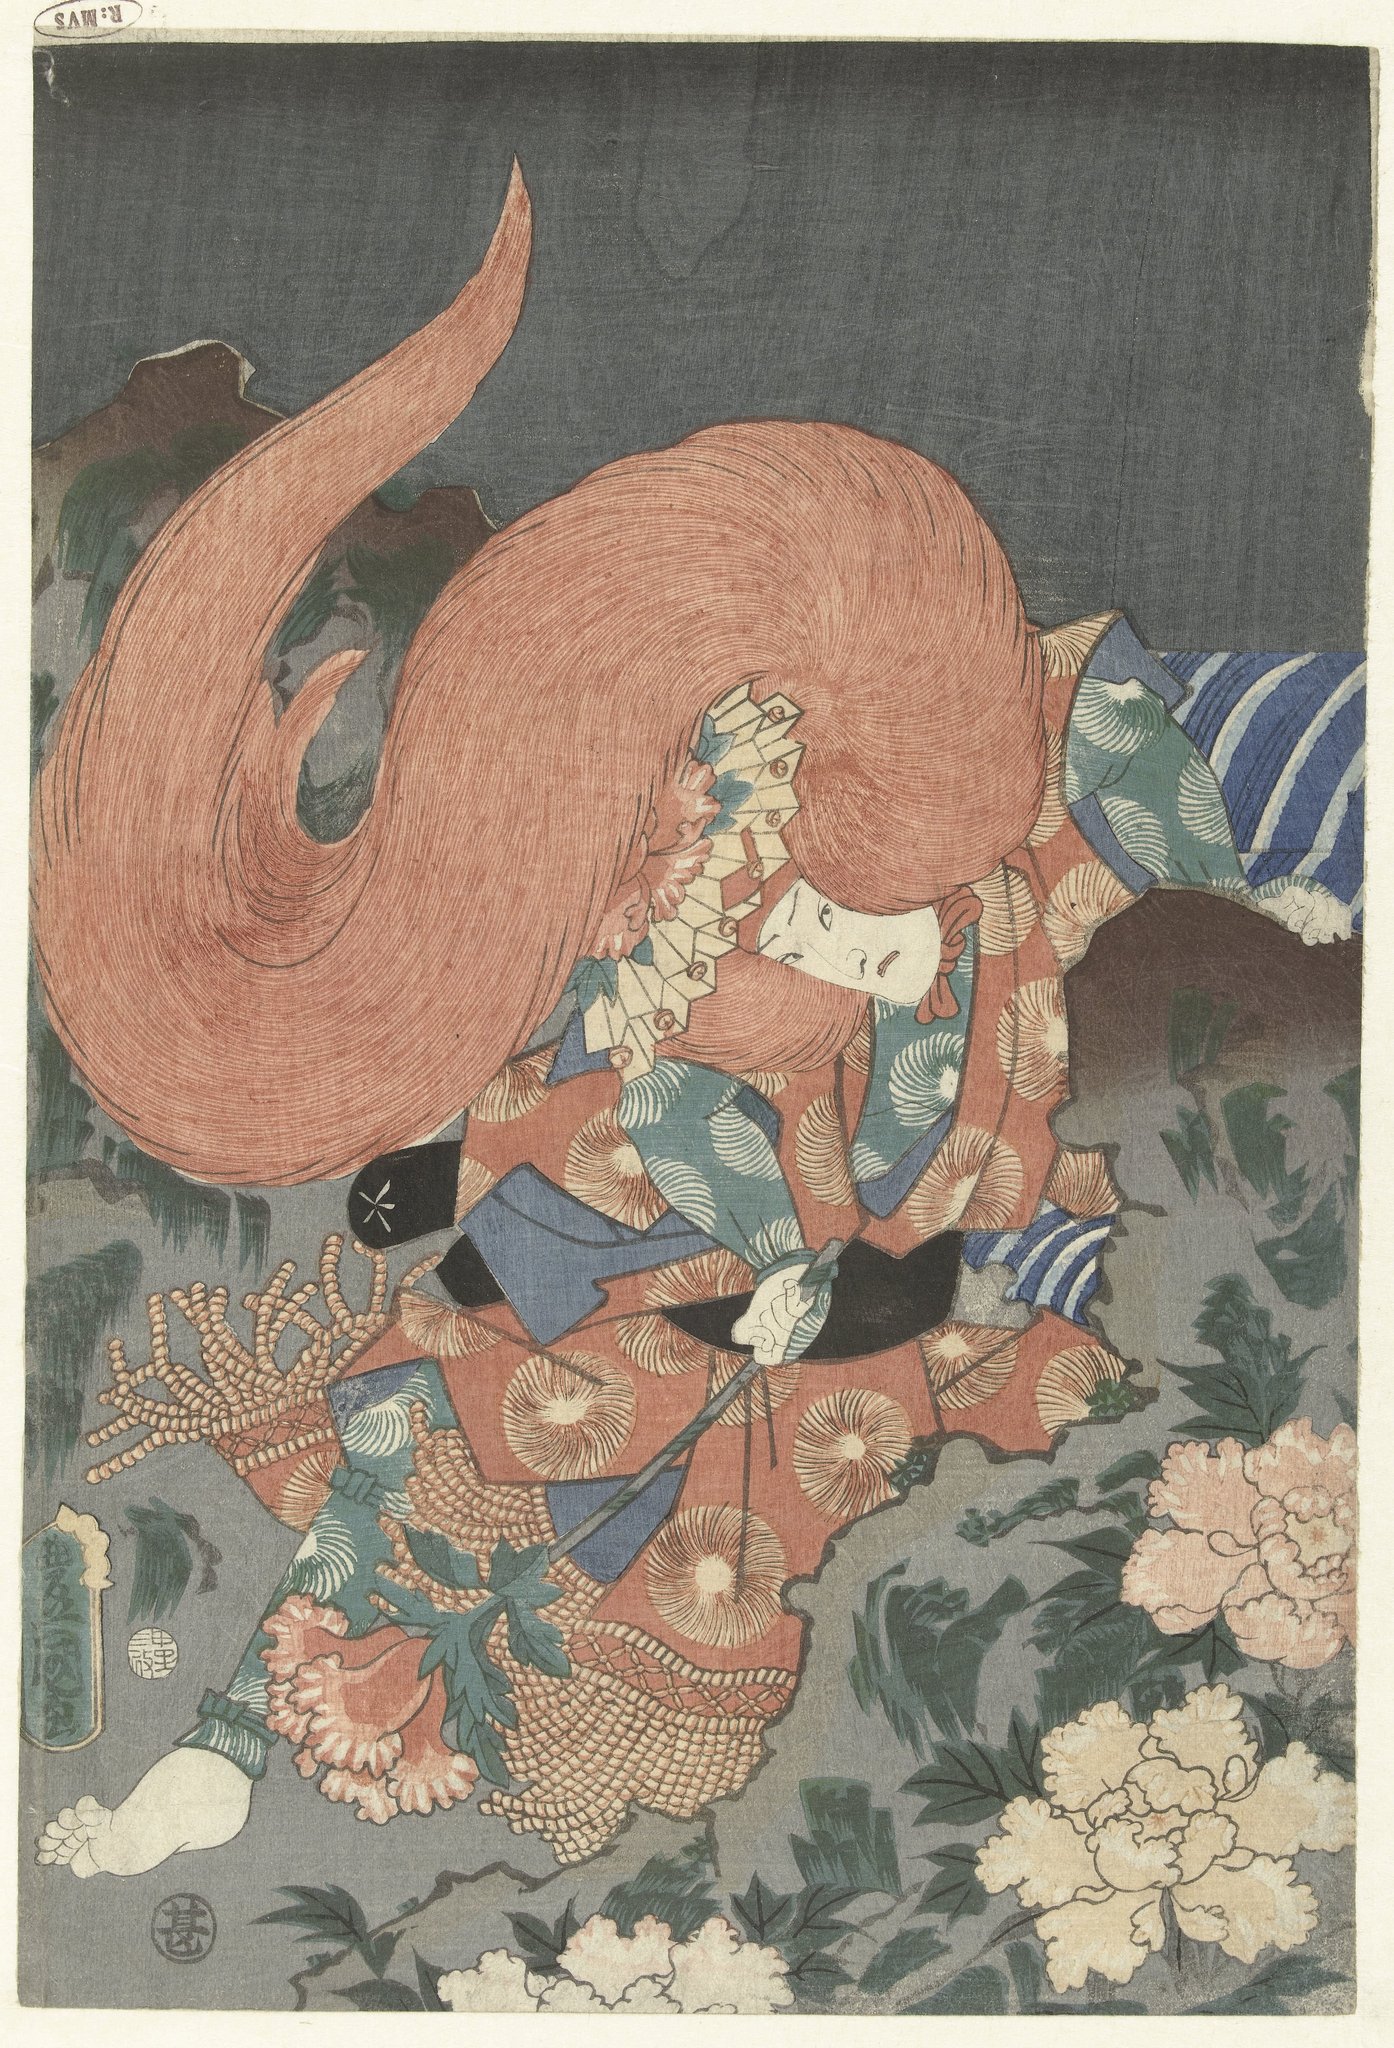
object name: print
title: Acteur als leeuwendanser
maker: utagawa kunisada (i)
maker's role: print maker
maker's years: 1786-1865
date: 1860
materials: paper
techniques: woodcut, nishiki e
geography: japan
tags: portrait of actor, actress, postures of the human figure, wig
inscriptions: collector's mark: Lugt 2228, collector's mark: Lugt 2760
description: Acteur met grote rode pruik, op blote voeten een leeuwendans uitvoerend tussen rotsen begroeid met pioenrozen; bij nacht.